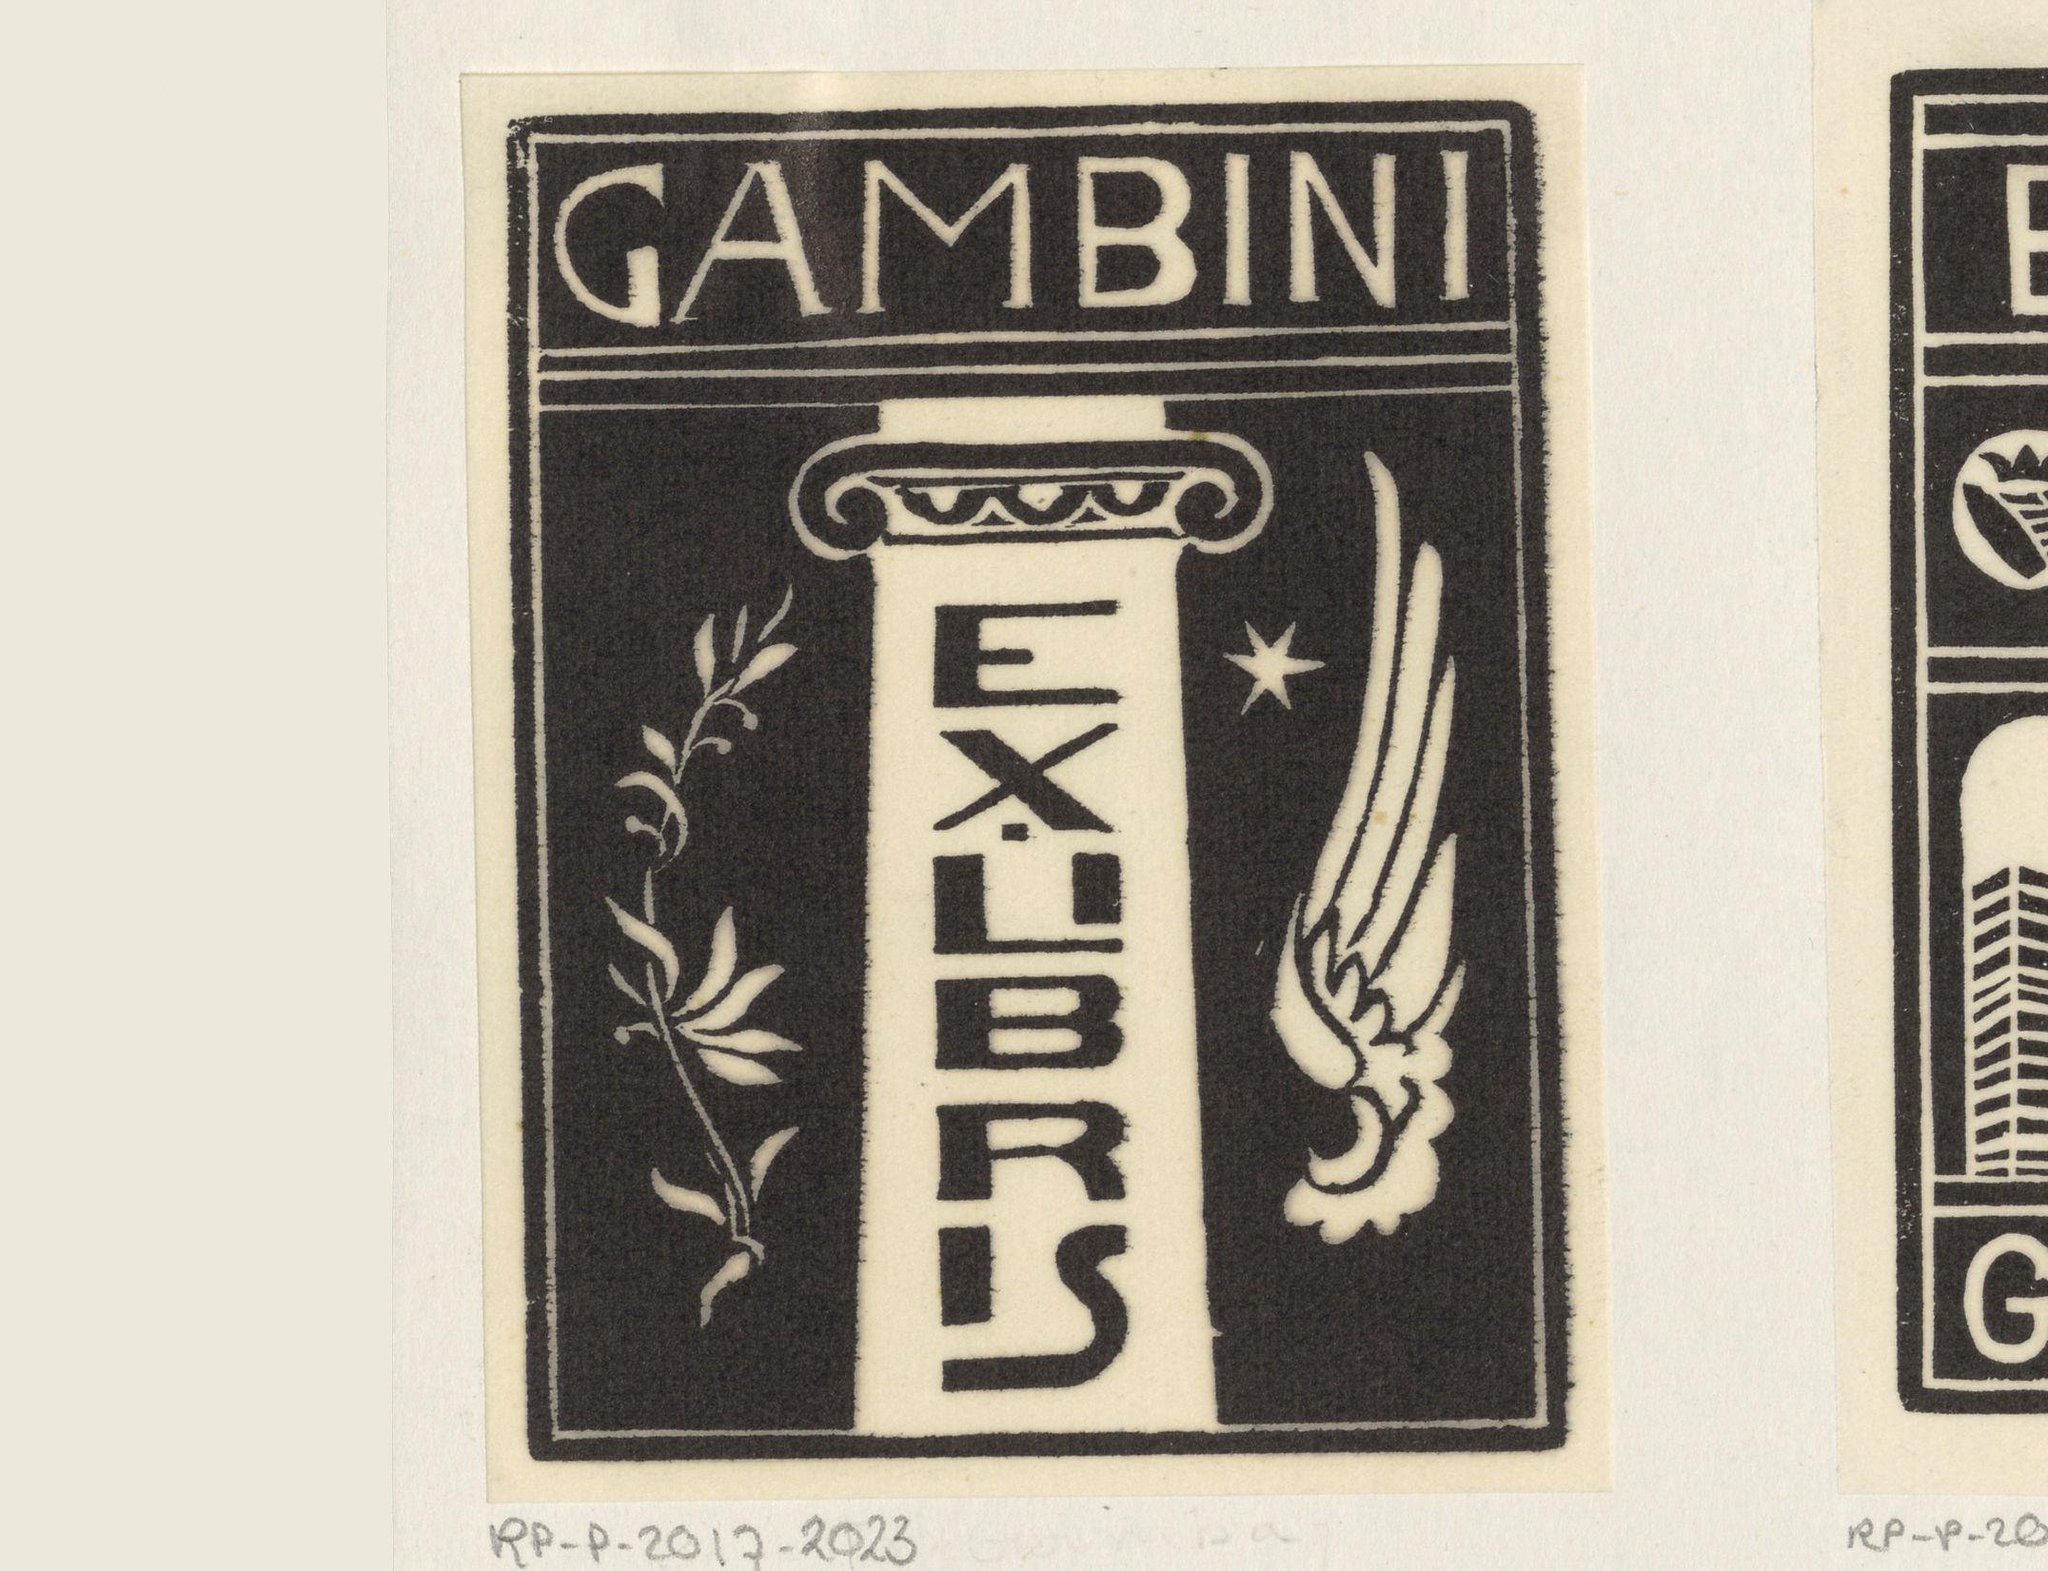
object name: bookplate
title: Ex libris van Gambini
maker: iörg gambini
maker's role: print maker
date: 1930-1950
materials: paper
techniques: woodcut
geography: italy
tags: iörg gambini, palmette ~ ornament, column, pillar ~ architecture, stars, angels